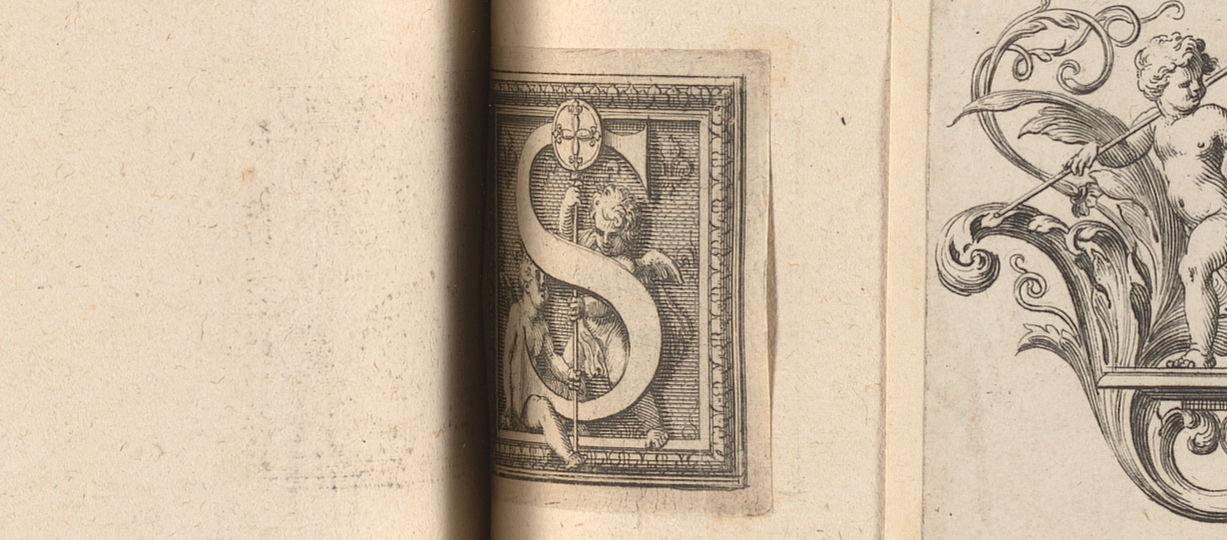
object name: print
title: Initiaal 'S' met twee engelen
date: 1687-1701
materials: paper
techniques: etching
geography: toulouse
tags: cherubs, i.e. children's heads with wings, initial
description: Prent gebruikt voor: La Faille, Germain de. Annales de la ville de Toulouse depuis la réunion de la Comté de Toulouse à la couronne (...). Toulouse: Guillaume-Louis Colomyez en Jérôme Posuel, 1687-1701.